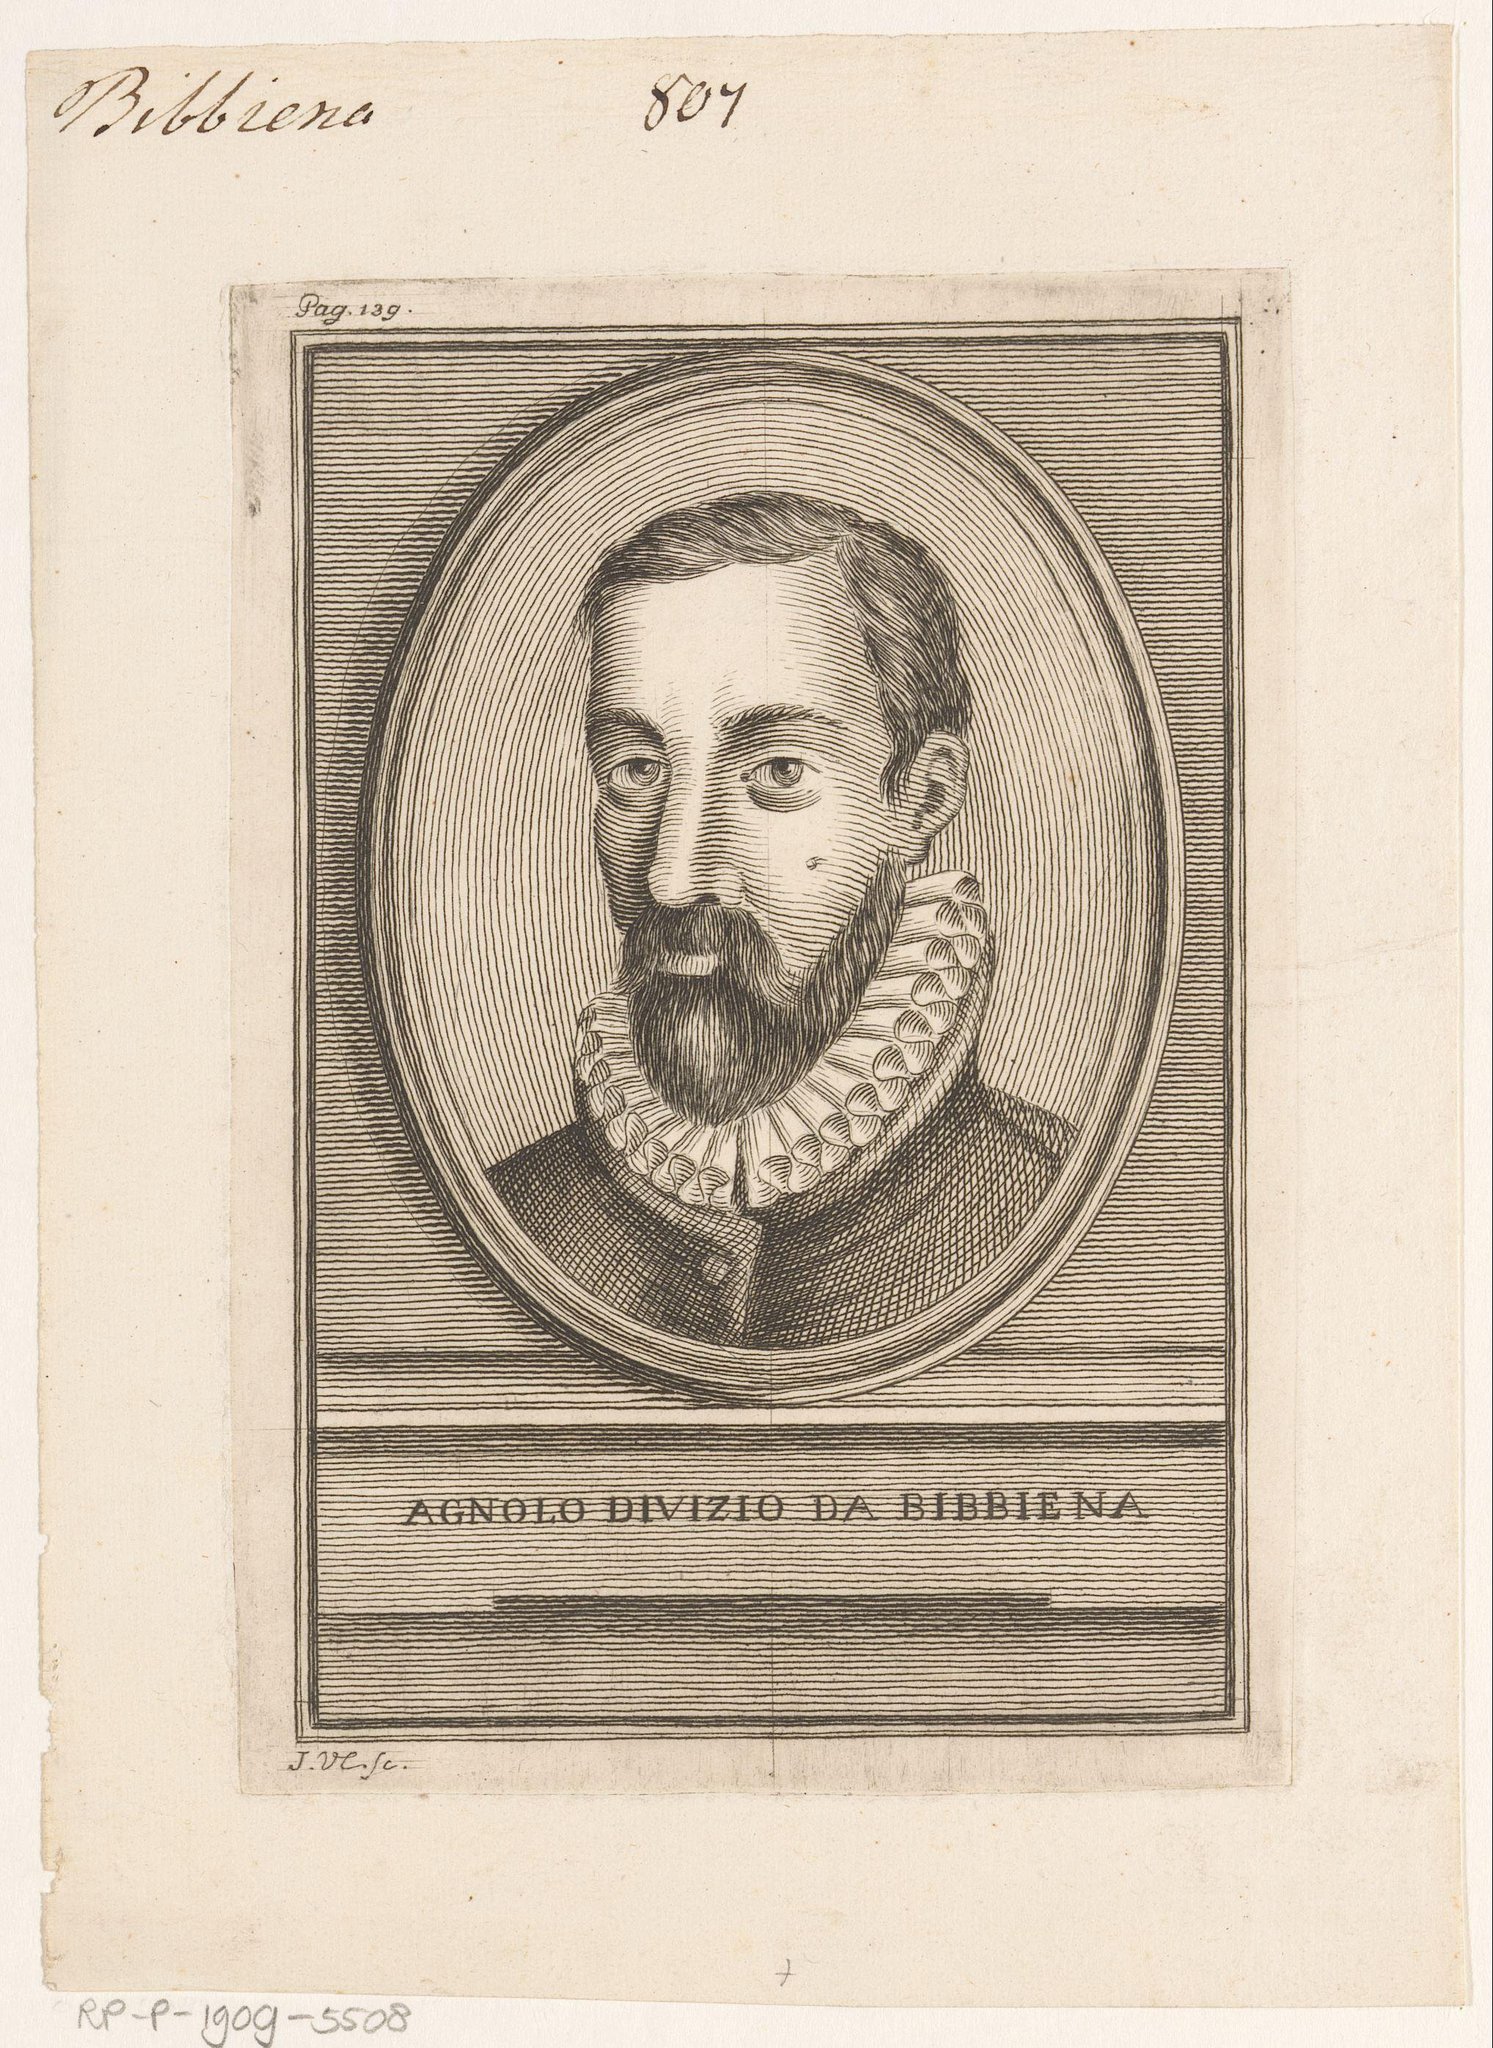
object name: book illustration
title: Portret van liedschrijver Agnolo Divizio da Bibbiena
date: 1750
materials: paper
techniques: engraving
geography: lucca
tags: historical persons, portrait of a writer, writer, poet, author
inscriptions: collector's mark: Lugt 2228, inscription: ‘Bibbiena / 807’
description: Prent gebruikt voor Grazzini, Anton Francesco. Tutti i trionfi, carri, mascherate o canti carnascialeschi andati per Firenze dal tempo del Magnifico Lorenzo de' Medici fino all' anno 1559 : in questa seconda edizione corretti, con diversi MSS. collazionati, delle loro varie lezioni arricchiti, notabilmente accresciuti, e co' ritratti di ciascun poeta adornate. Lucca: Cosmopoli, 1750.